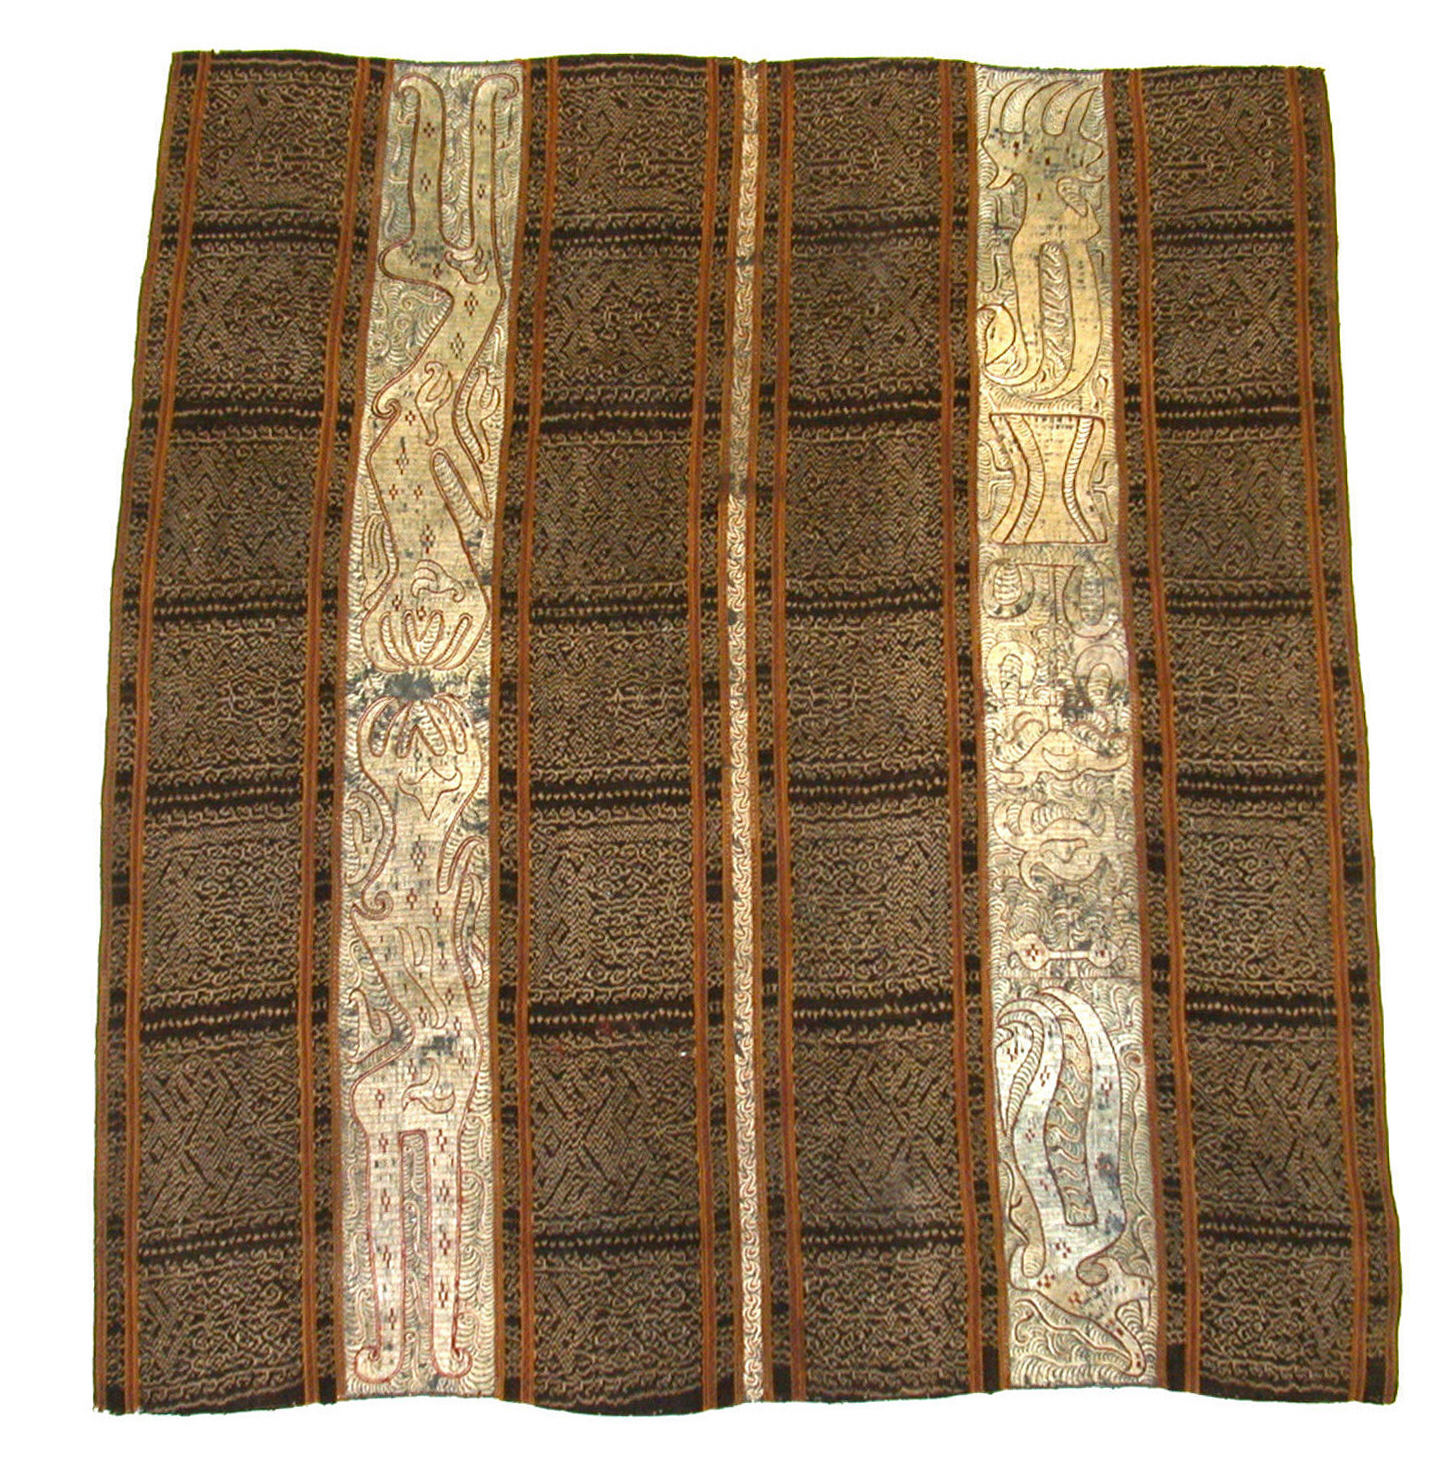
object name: skirt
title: Woman's Ceremonial Skirt (Tapis)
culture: lampung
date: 1701-1800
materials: cotton, silk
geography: indonesia